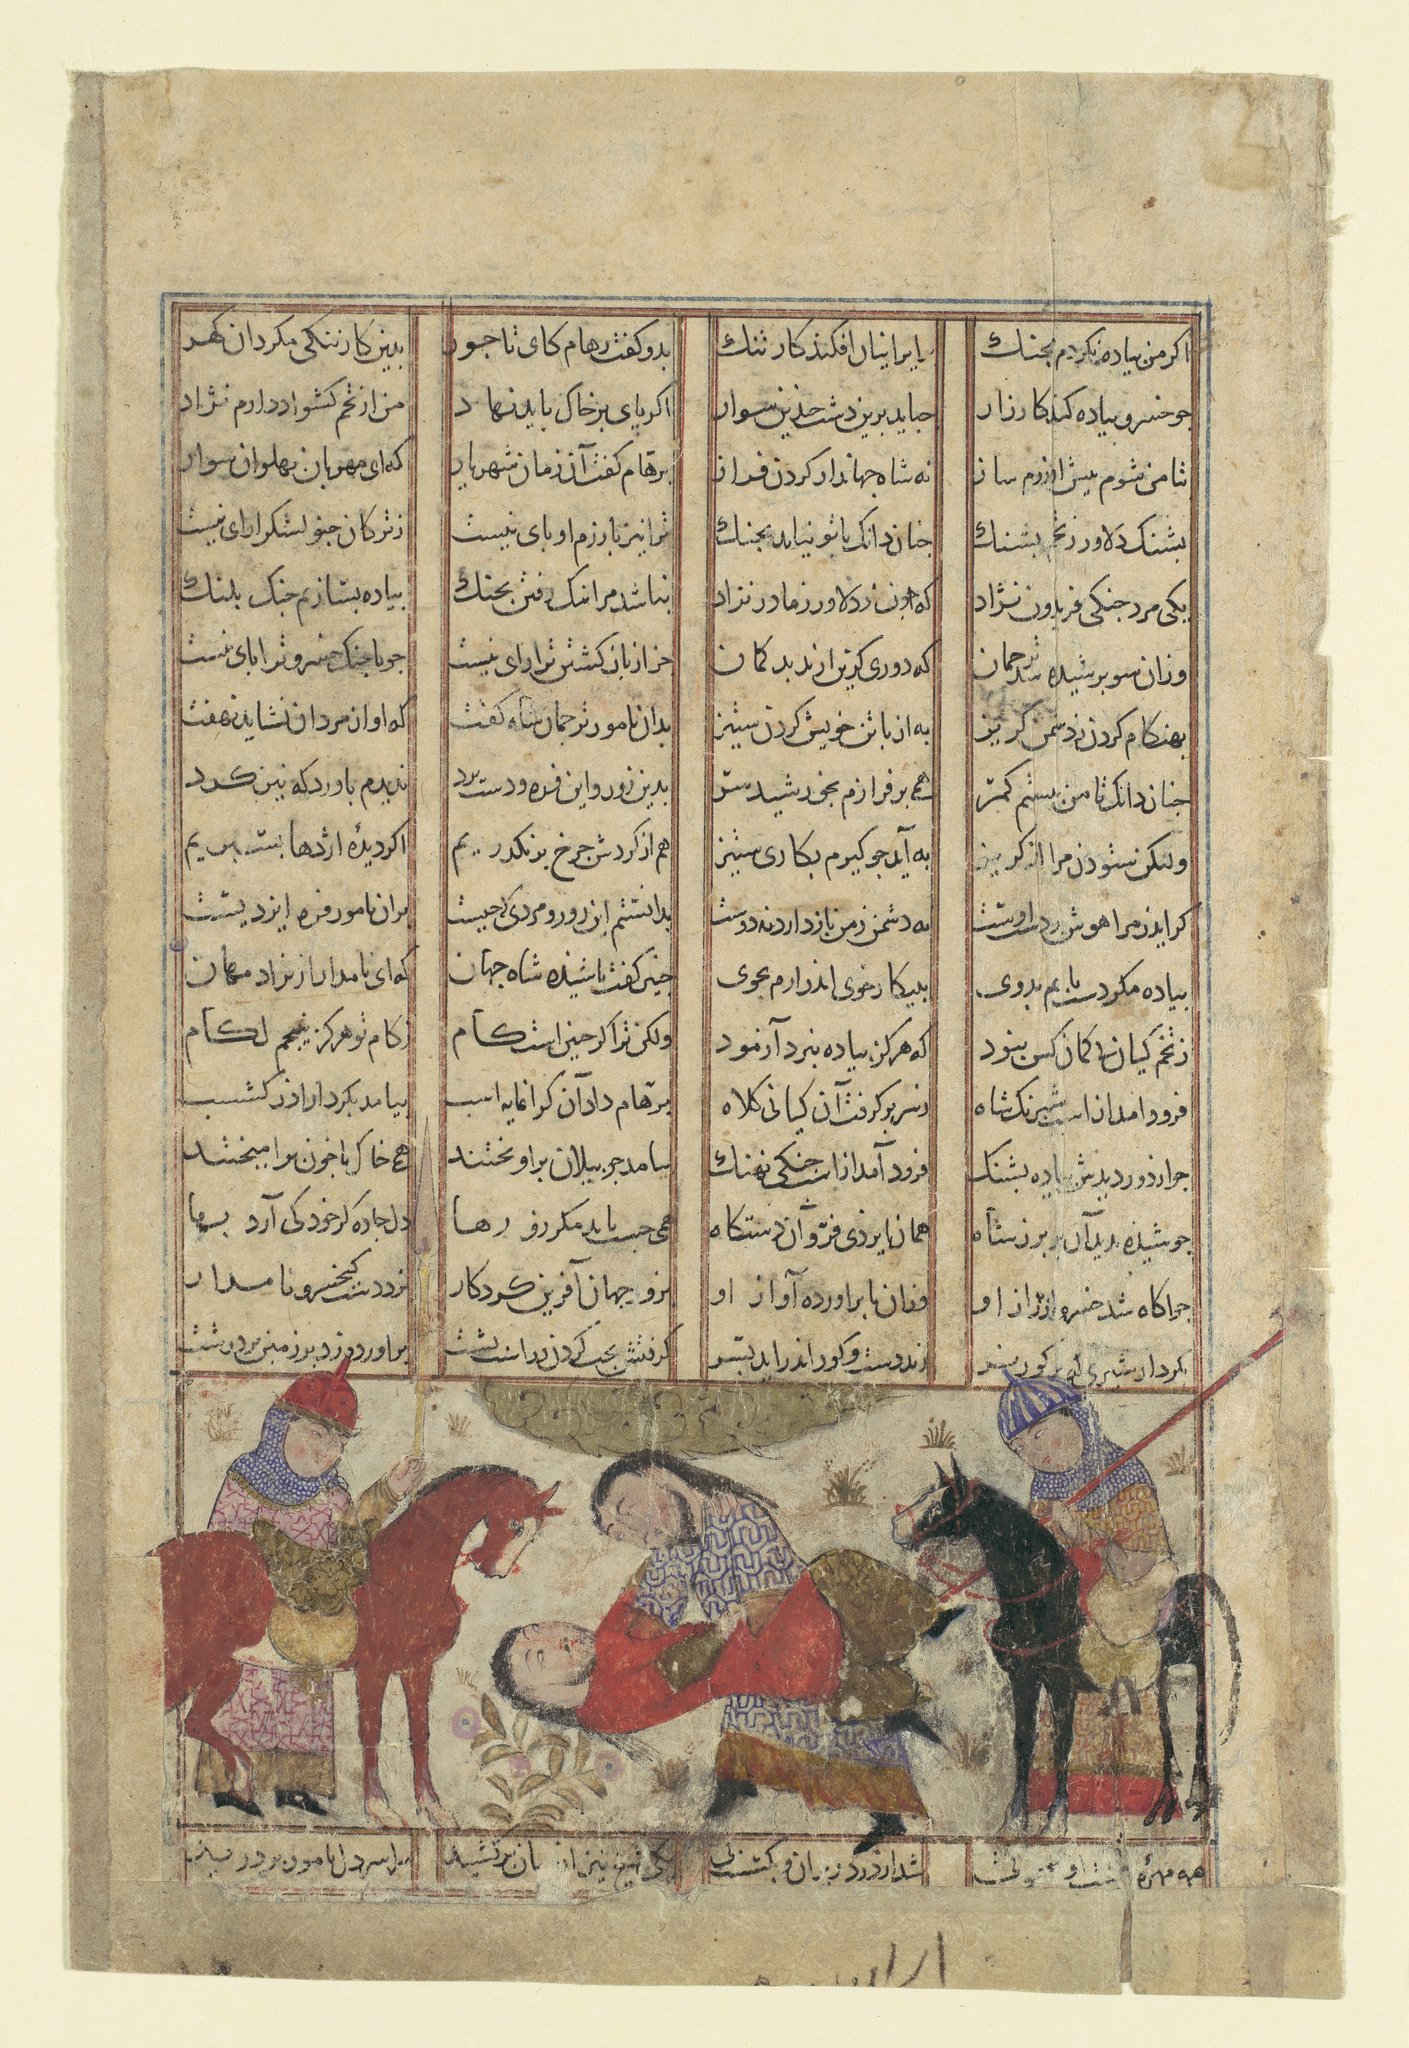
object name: folio from an illustrated manuscript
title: "Kai Khusrau Wrestles with Shida", Folio from a Shahnama (Book of Kings)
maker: abu'l qasim firdausi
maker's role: author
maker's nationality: iranian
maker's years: 935-1020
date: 1330-1340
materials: gold, ink, paper, silver, watercolor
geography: iran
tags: poetry,men,horses